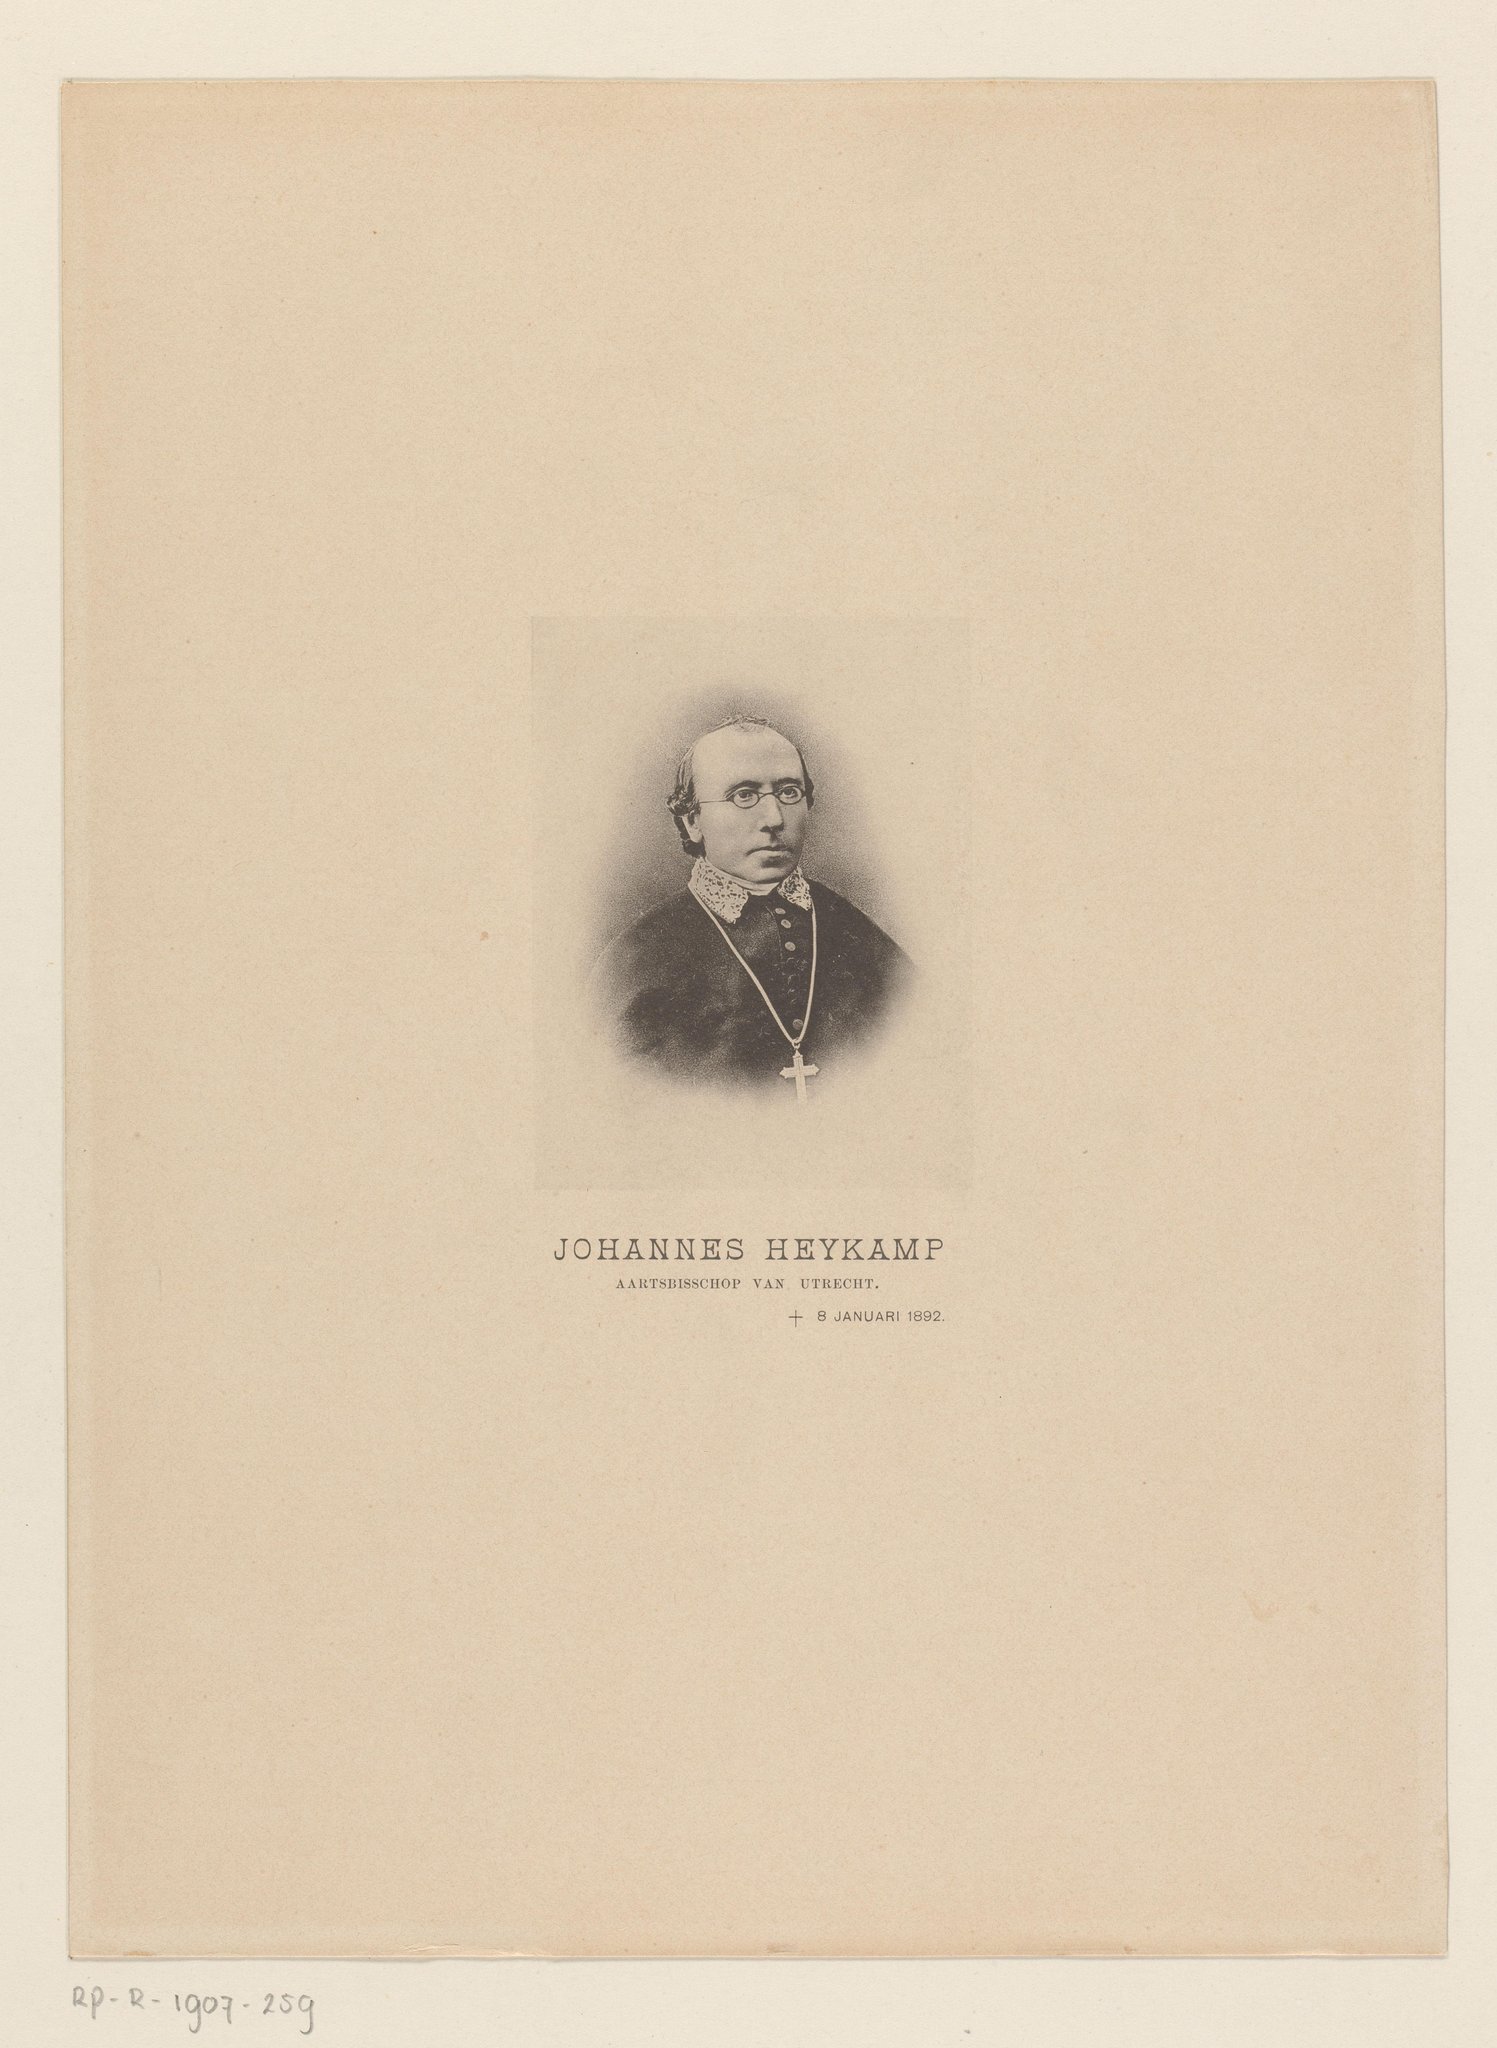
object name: photomechanical print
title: Johannes Heykamp. Aartsbisschop van Utrecht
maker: Anonymous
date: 1880-1892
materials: paper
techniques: photograph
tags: archbishop, bishop, etc. (roman catholic), historical persons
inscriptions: collector's mark: Lugt 2166, inscription: ‘+ 8 JANUARI 1892.’